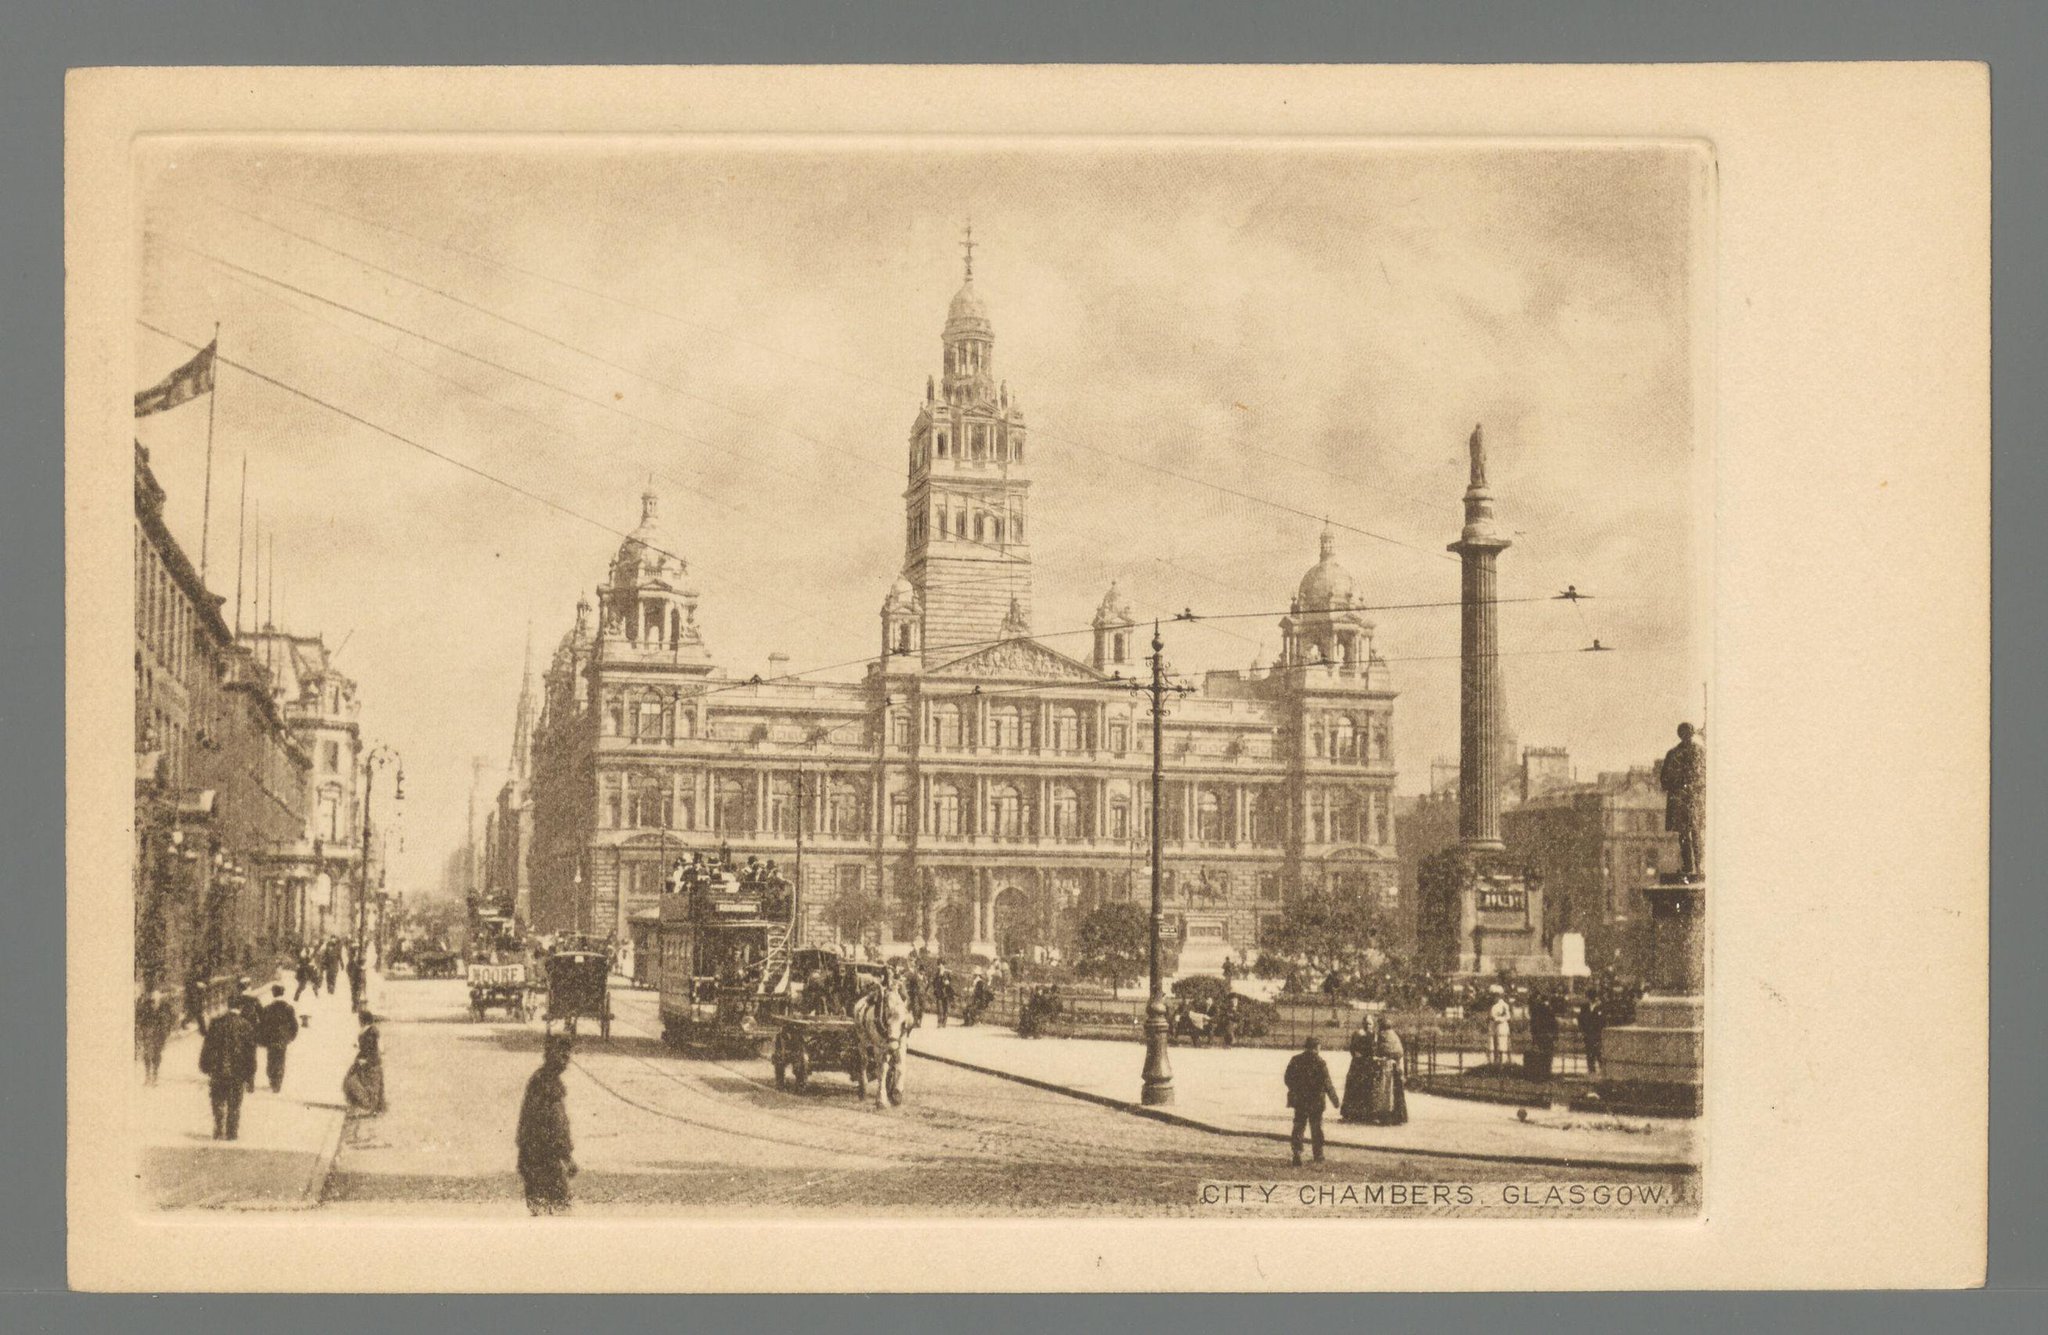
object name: photomechanical print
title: City Chambers. Glasgow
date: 1894-1905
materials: cardboard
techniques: photoaquatint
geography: glasgow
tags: monument, statue, street, glasgow